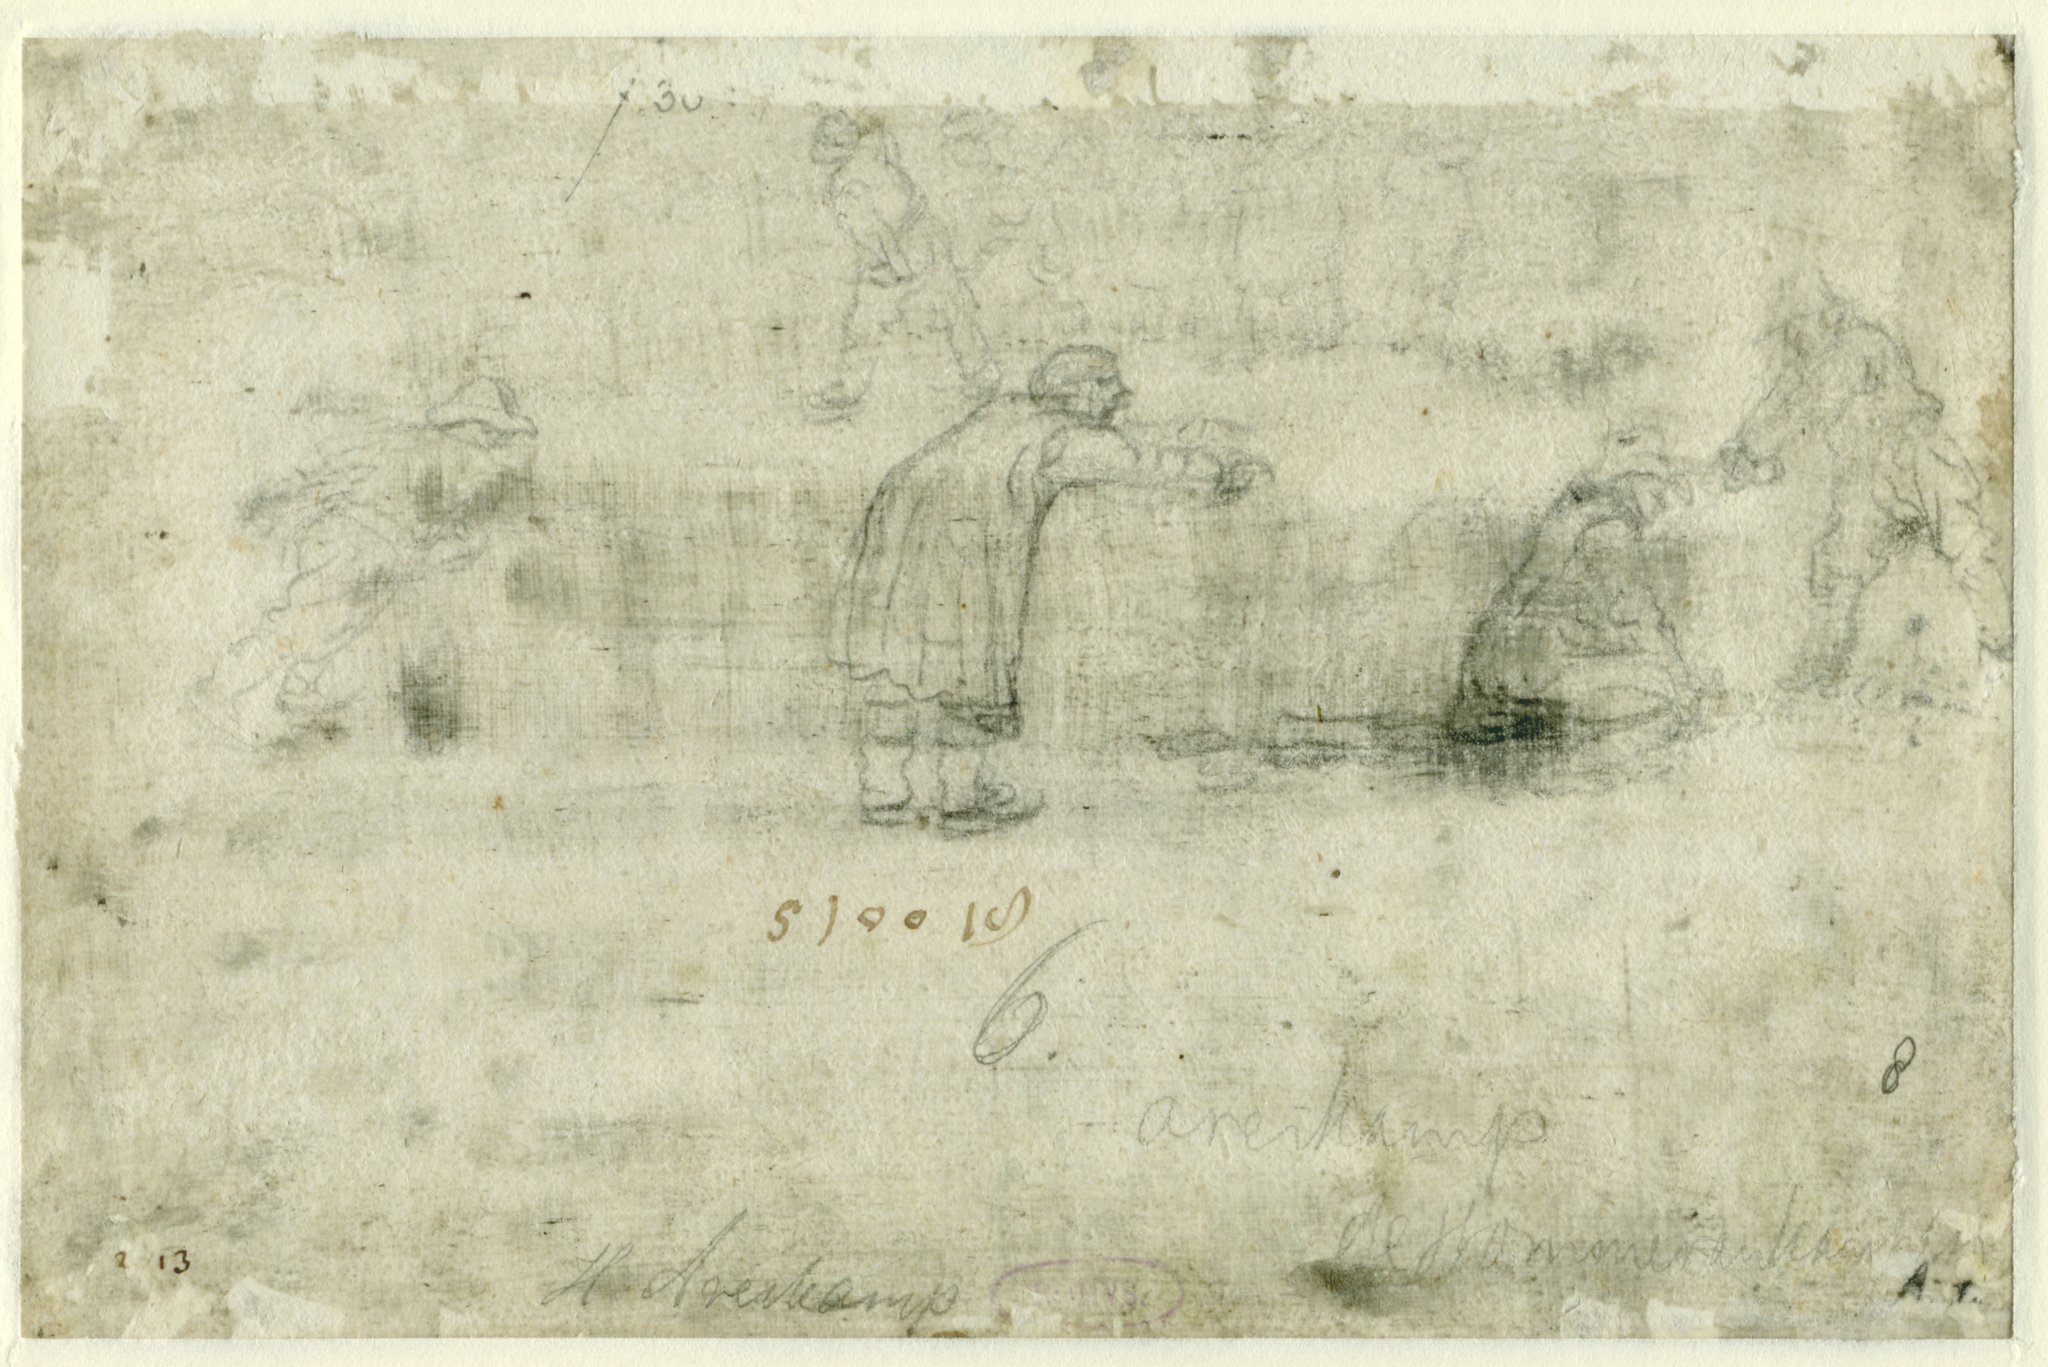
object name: drawing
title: Sketches of Figures on the Ice / recto: Winter Scene on the Frozen Canal near the Kalverhekkenpoort, Kampen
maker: hendrick avercamp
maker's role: draughtsman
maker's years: 1585-1634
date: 1607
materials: graphite, paper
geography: kampen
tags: skates (winter sports)